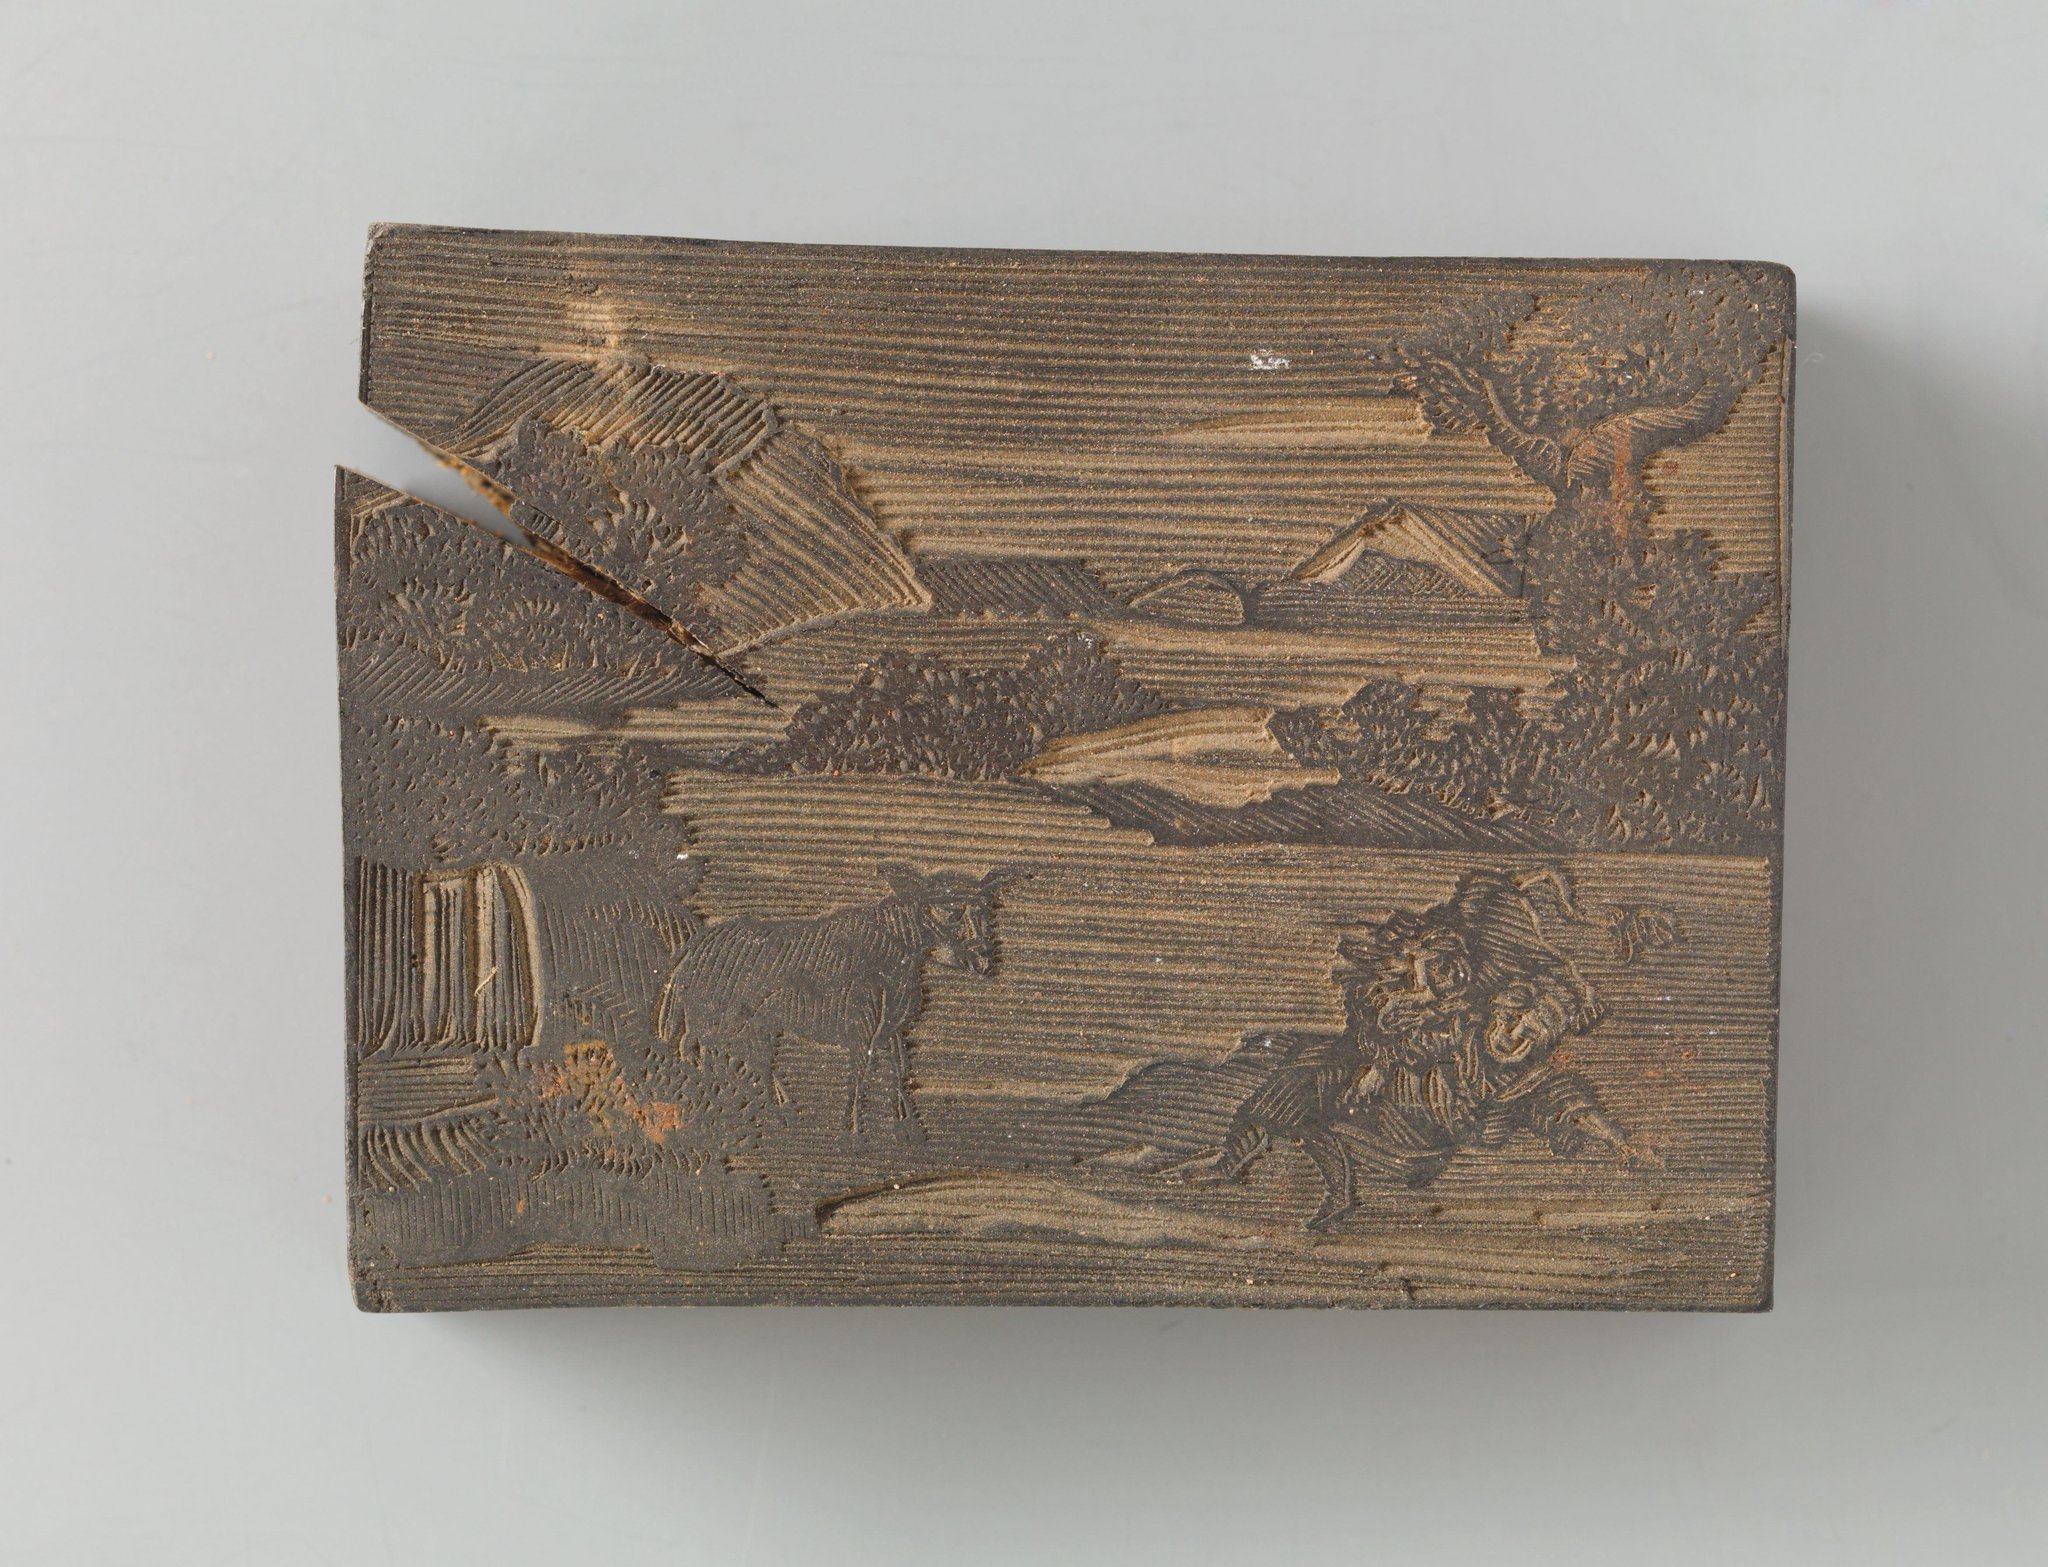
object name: wood block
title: Bijbel-illustraties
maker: Anonymous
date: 1550-1699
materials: wood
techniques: woodcut